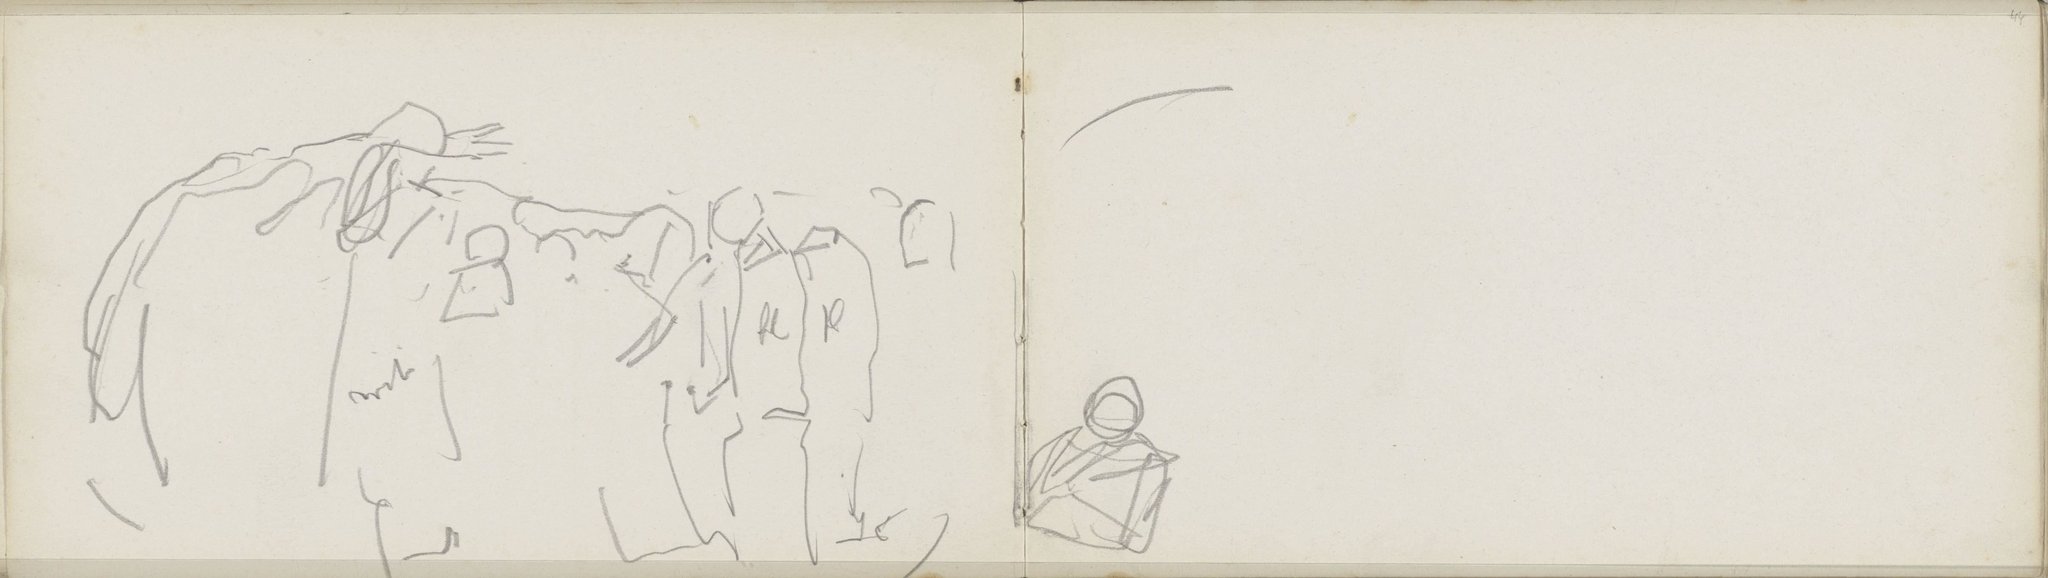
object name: sketchbook leaf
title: Figuurstudies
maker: george hendrik breitner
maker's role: draughtsman, painter, print maker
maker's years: 1857-1923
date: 1886-1923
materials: paper, pencil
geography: amsterdam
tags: adult woman, adult man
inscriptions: kleurnotitie, handgeschreven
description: Pagina 43 en pagina 44 uit een schetsboek met 39 bladen.